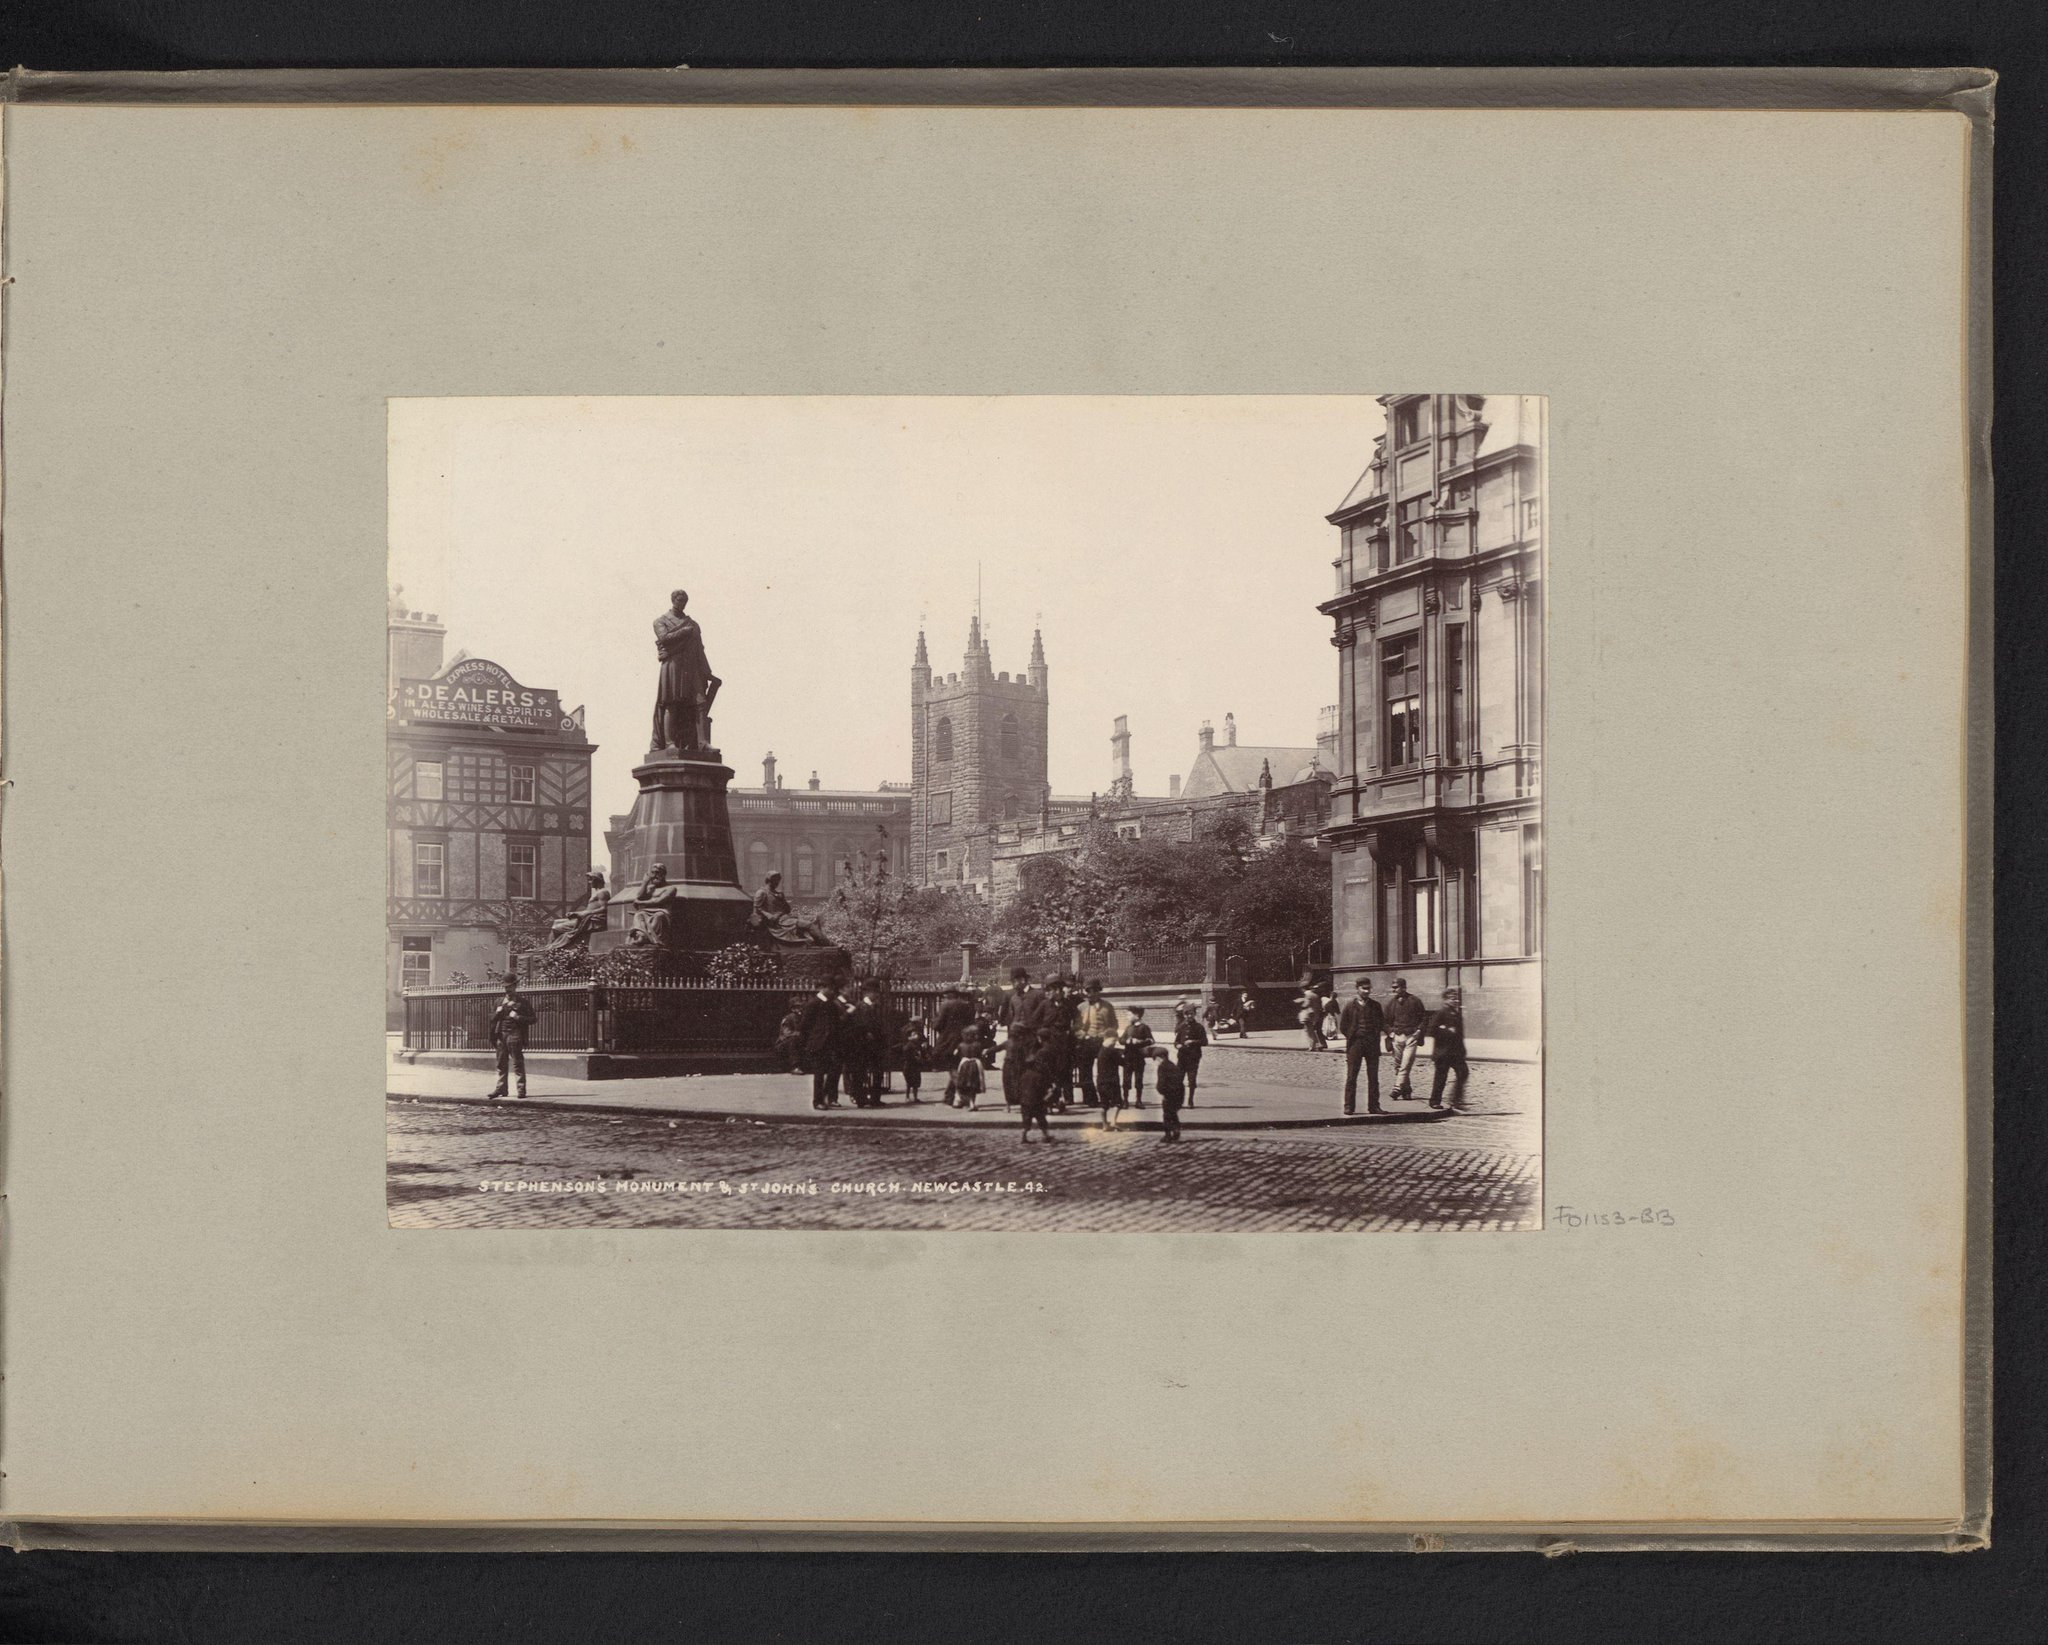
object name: photograph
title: George Stephenson's Monument en St. John's church te Newcastle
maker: Anonymous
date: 1880-1900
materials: photographic support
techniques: albumen print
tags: church (exterior), monument, statue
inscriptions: inscription: ‘Stephenson's Monument and St John's church, Newcastle. 42.’